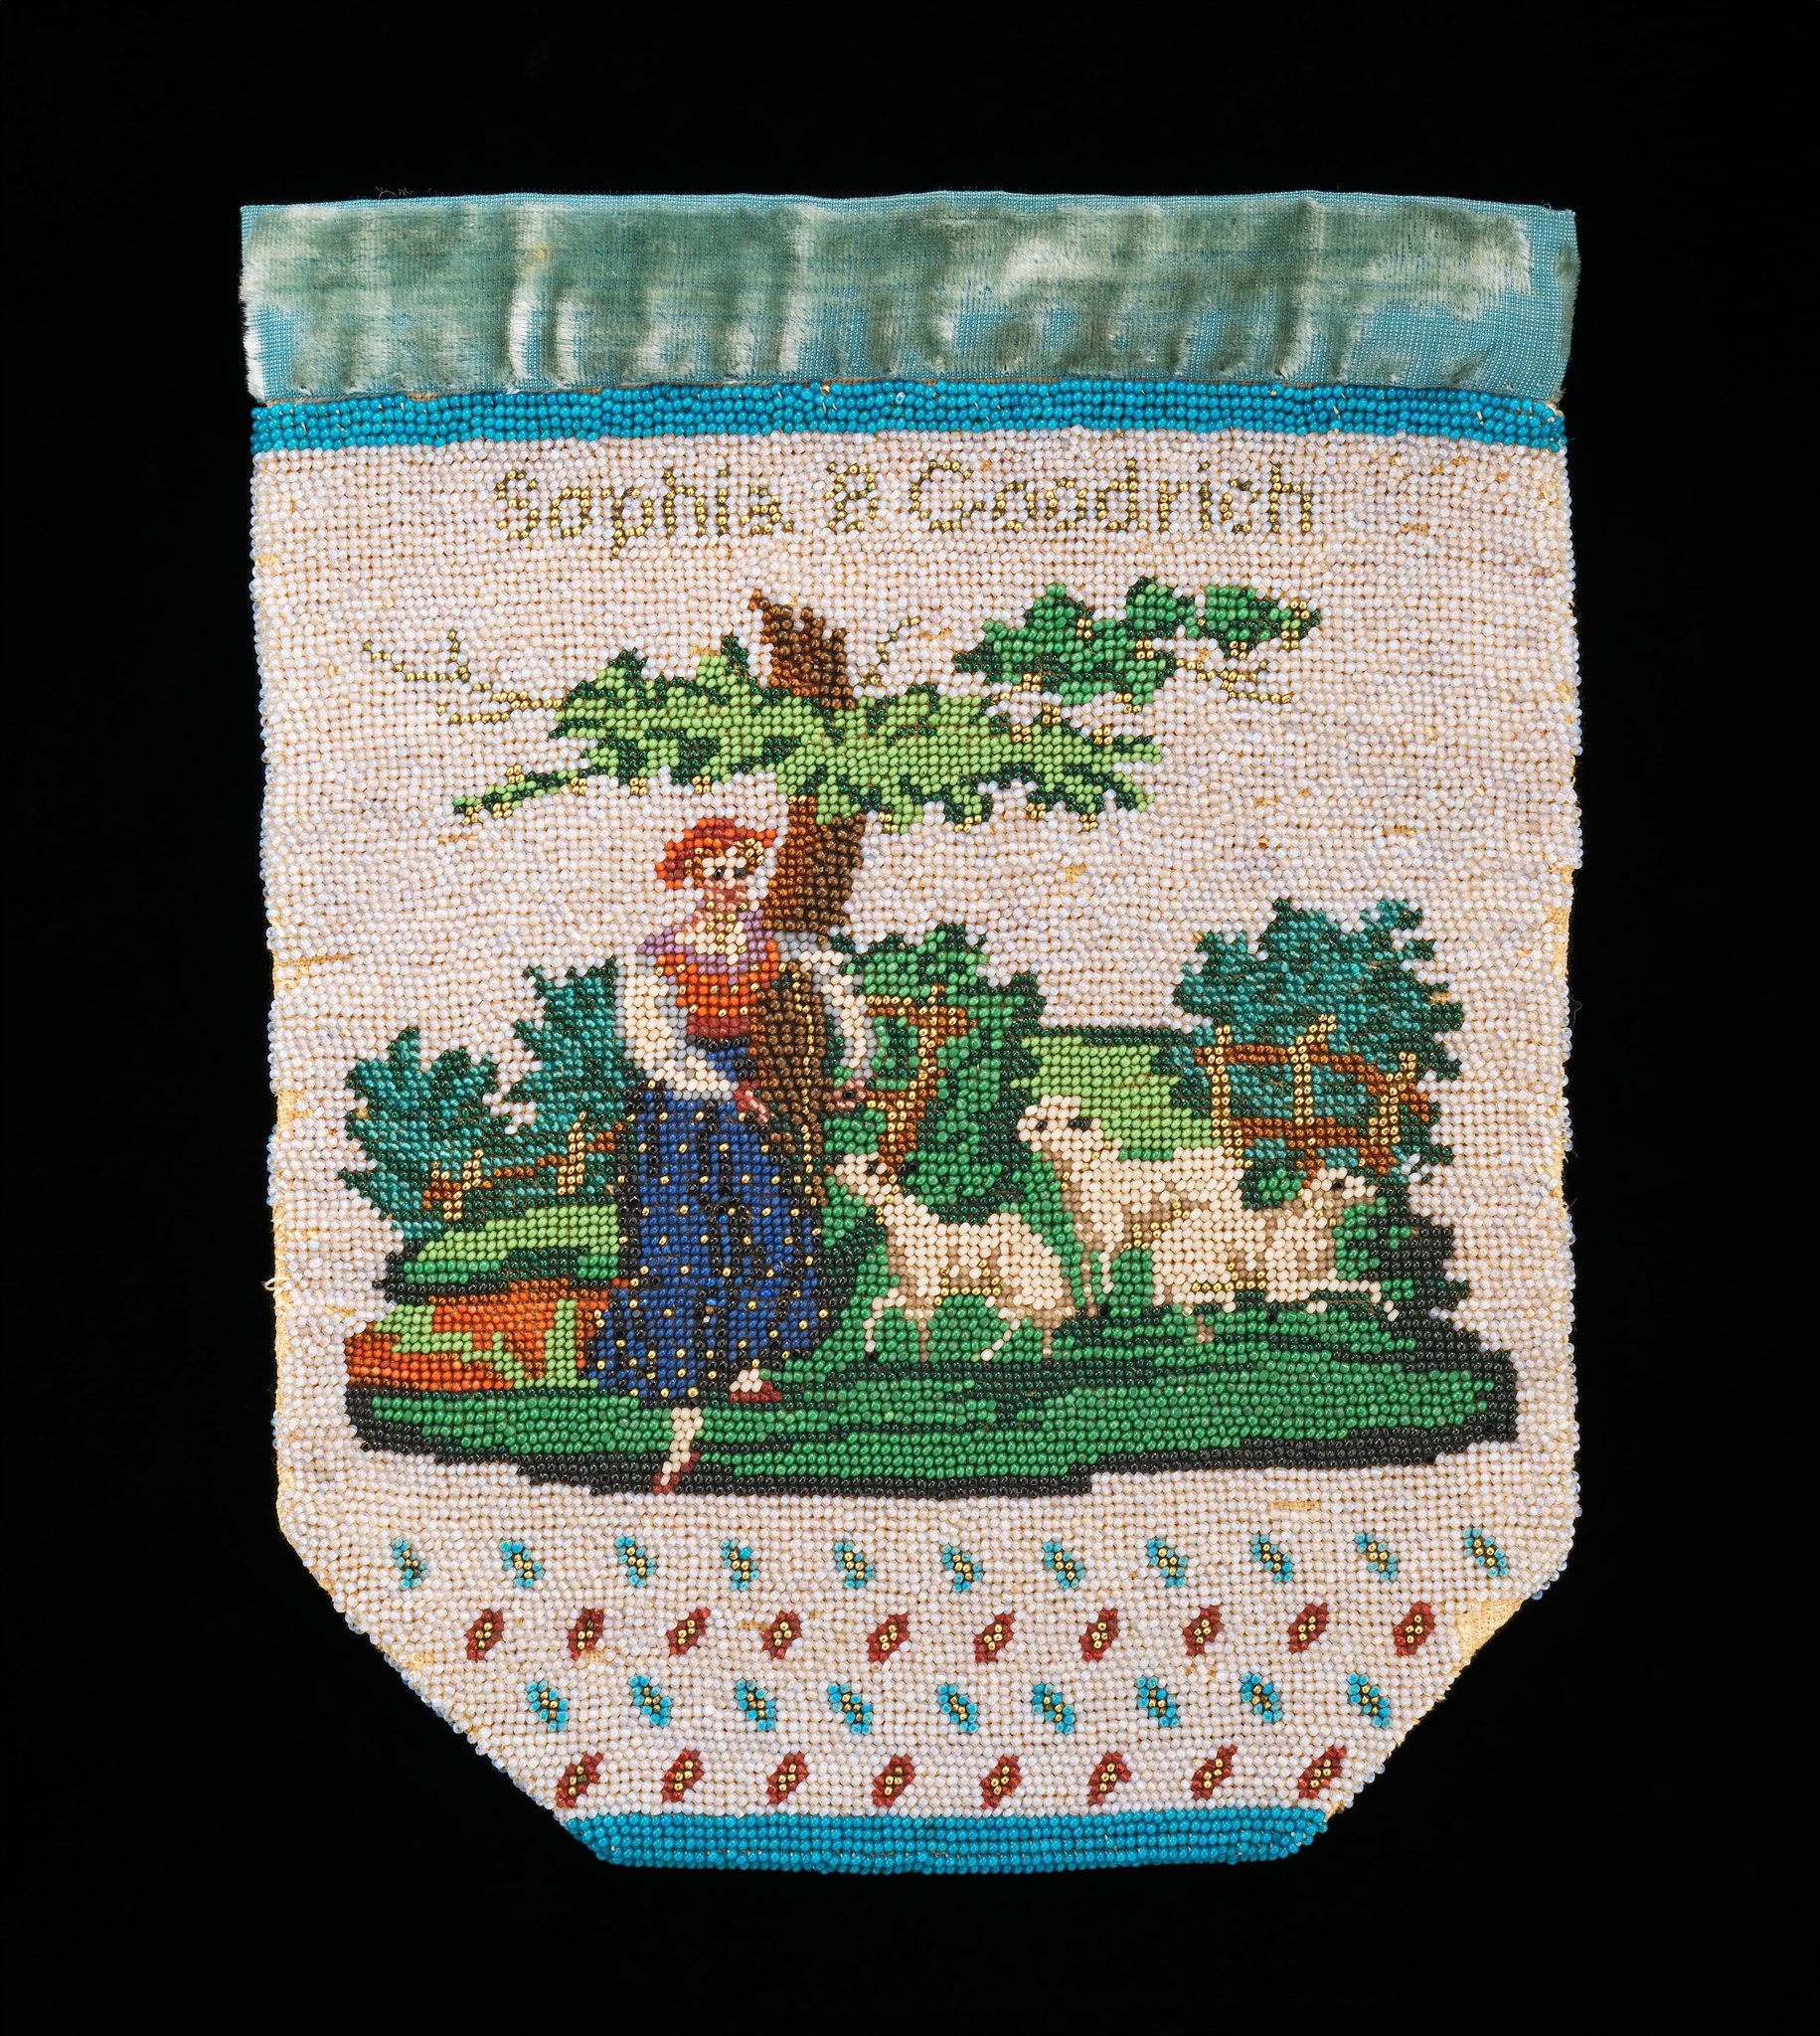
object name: pouch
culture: american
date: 1836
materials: glass, linen, silk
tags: women,sheep,trees